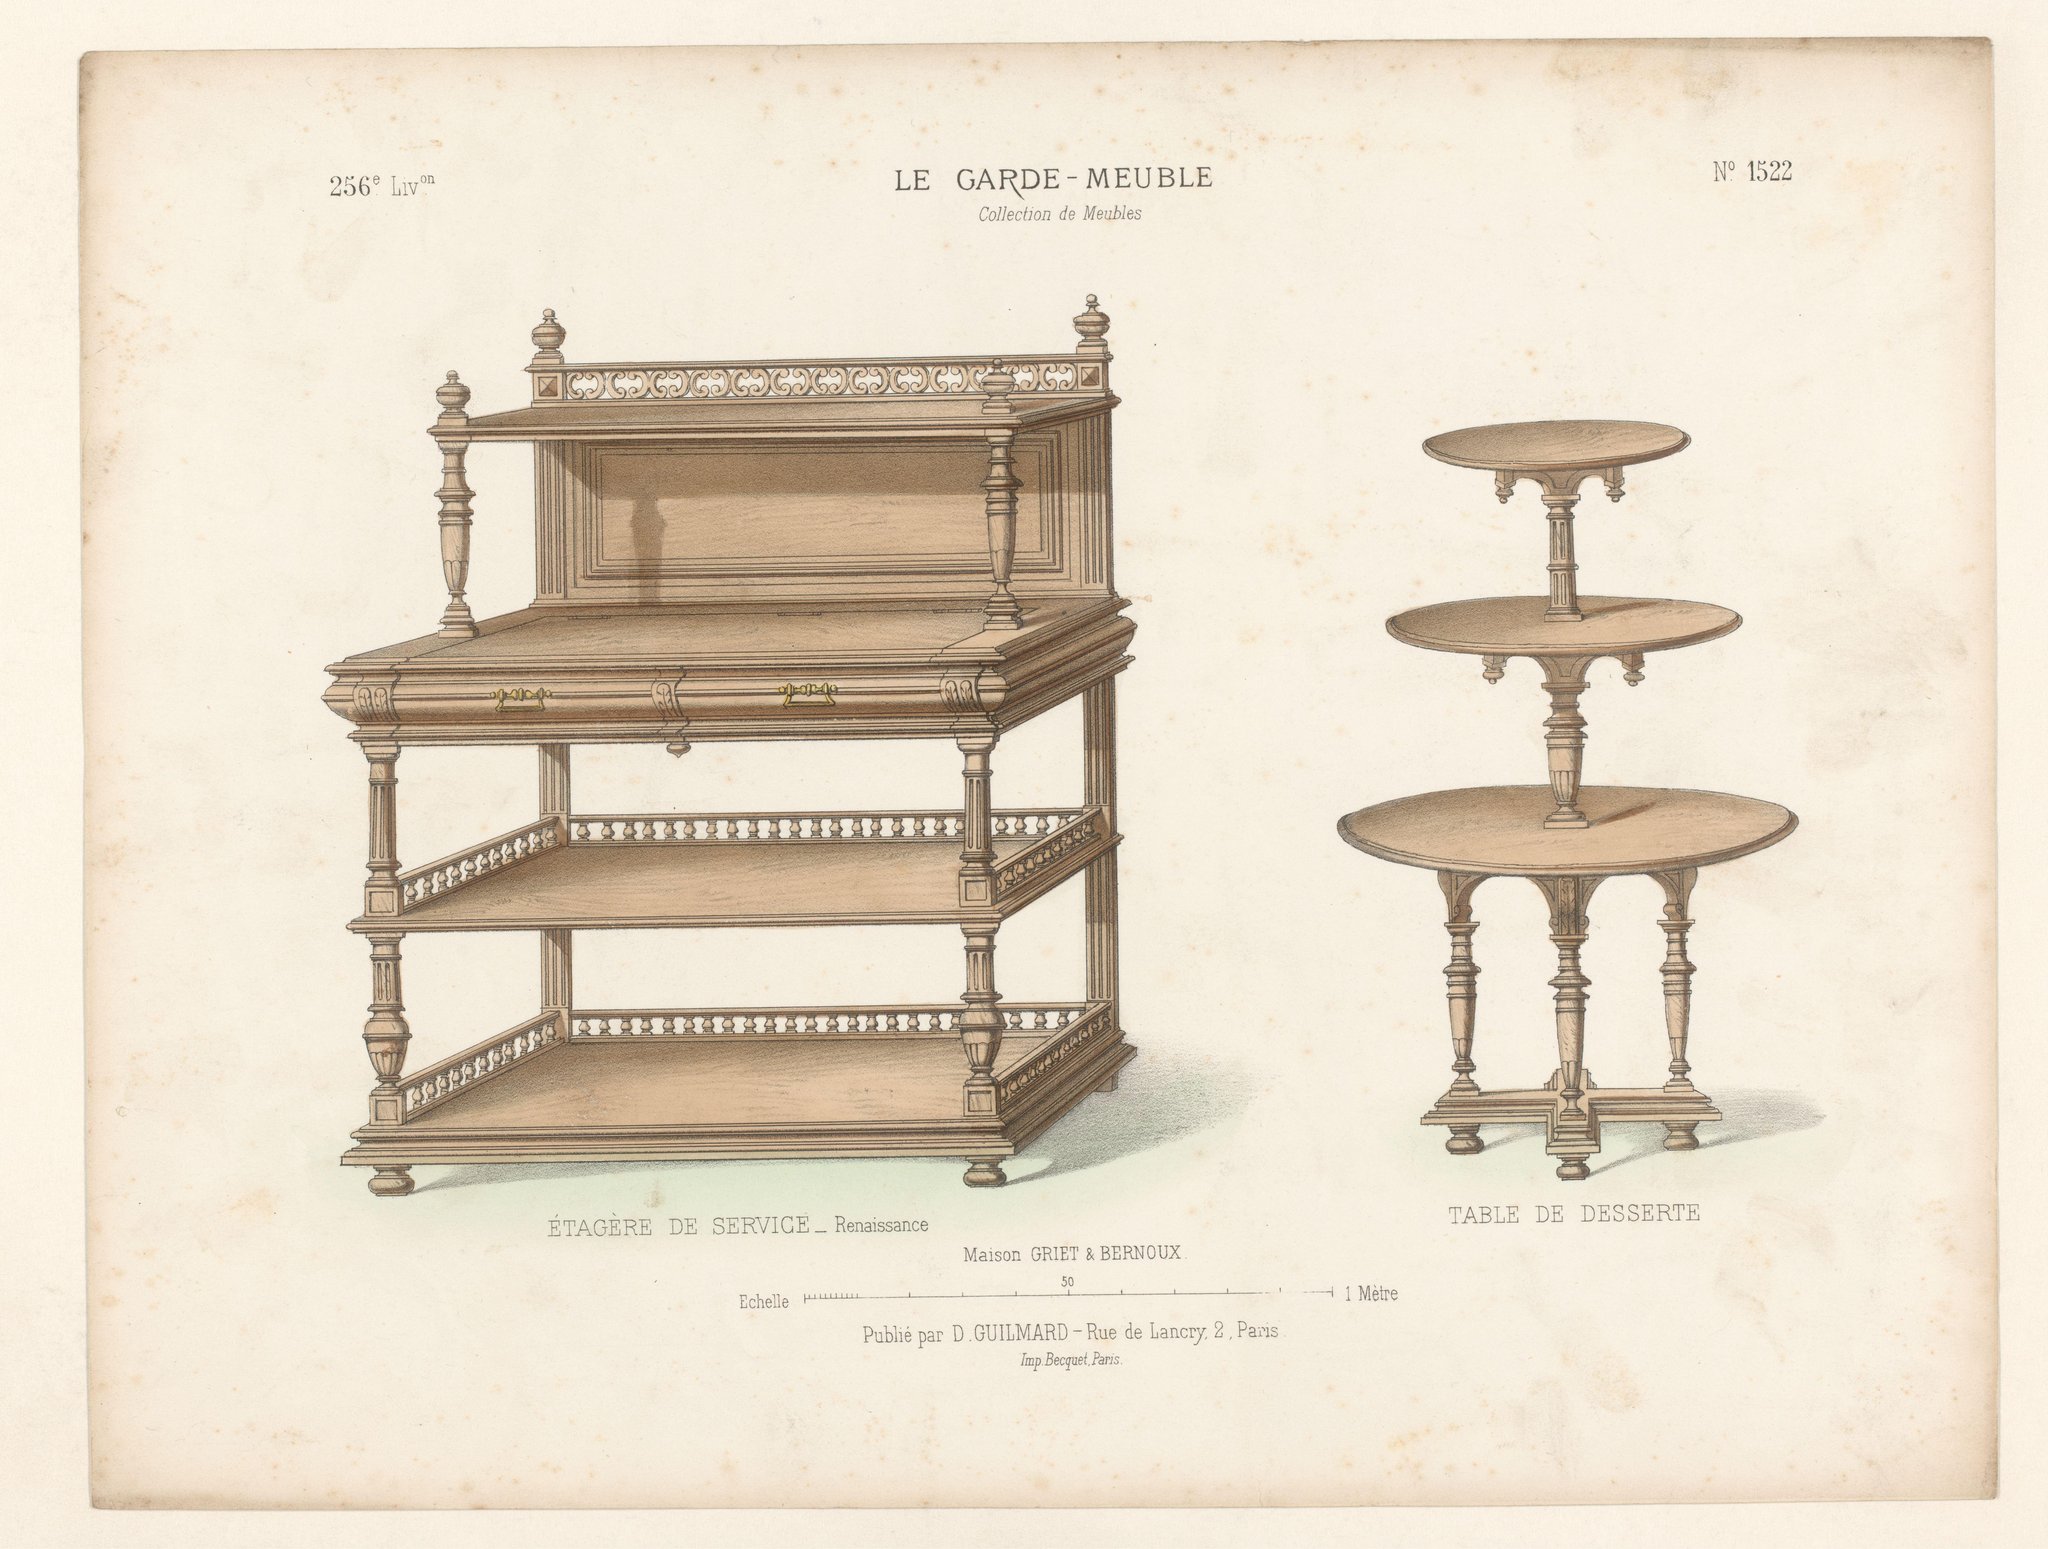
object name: print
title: Le garde-meuble / Collection de Meubles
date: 1839-1885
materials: paper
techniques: hand coloring, lithograph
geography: paris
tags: furniture for storage, table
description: Ieder Livraison in de serie Le Garde-Meuble bevat negen platen: drie 'sièges' (zitmeubels), drie 'meubles' (diverse meubels zoals tafels en kasten) en drie 'tentures' (gordijnen en draperieën).